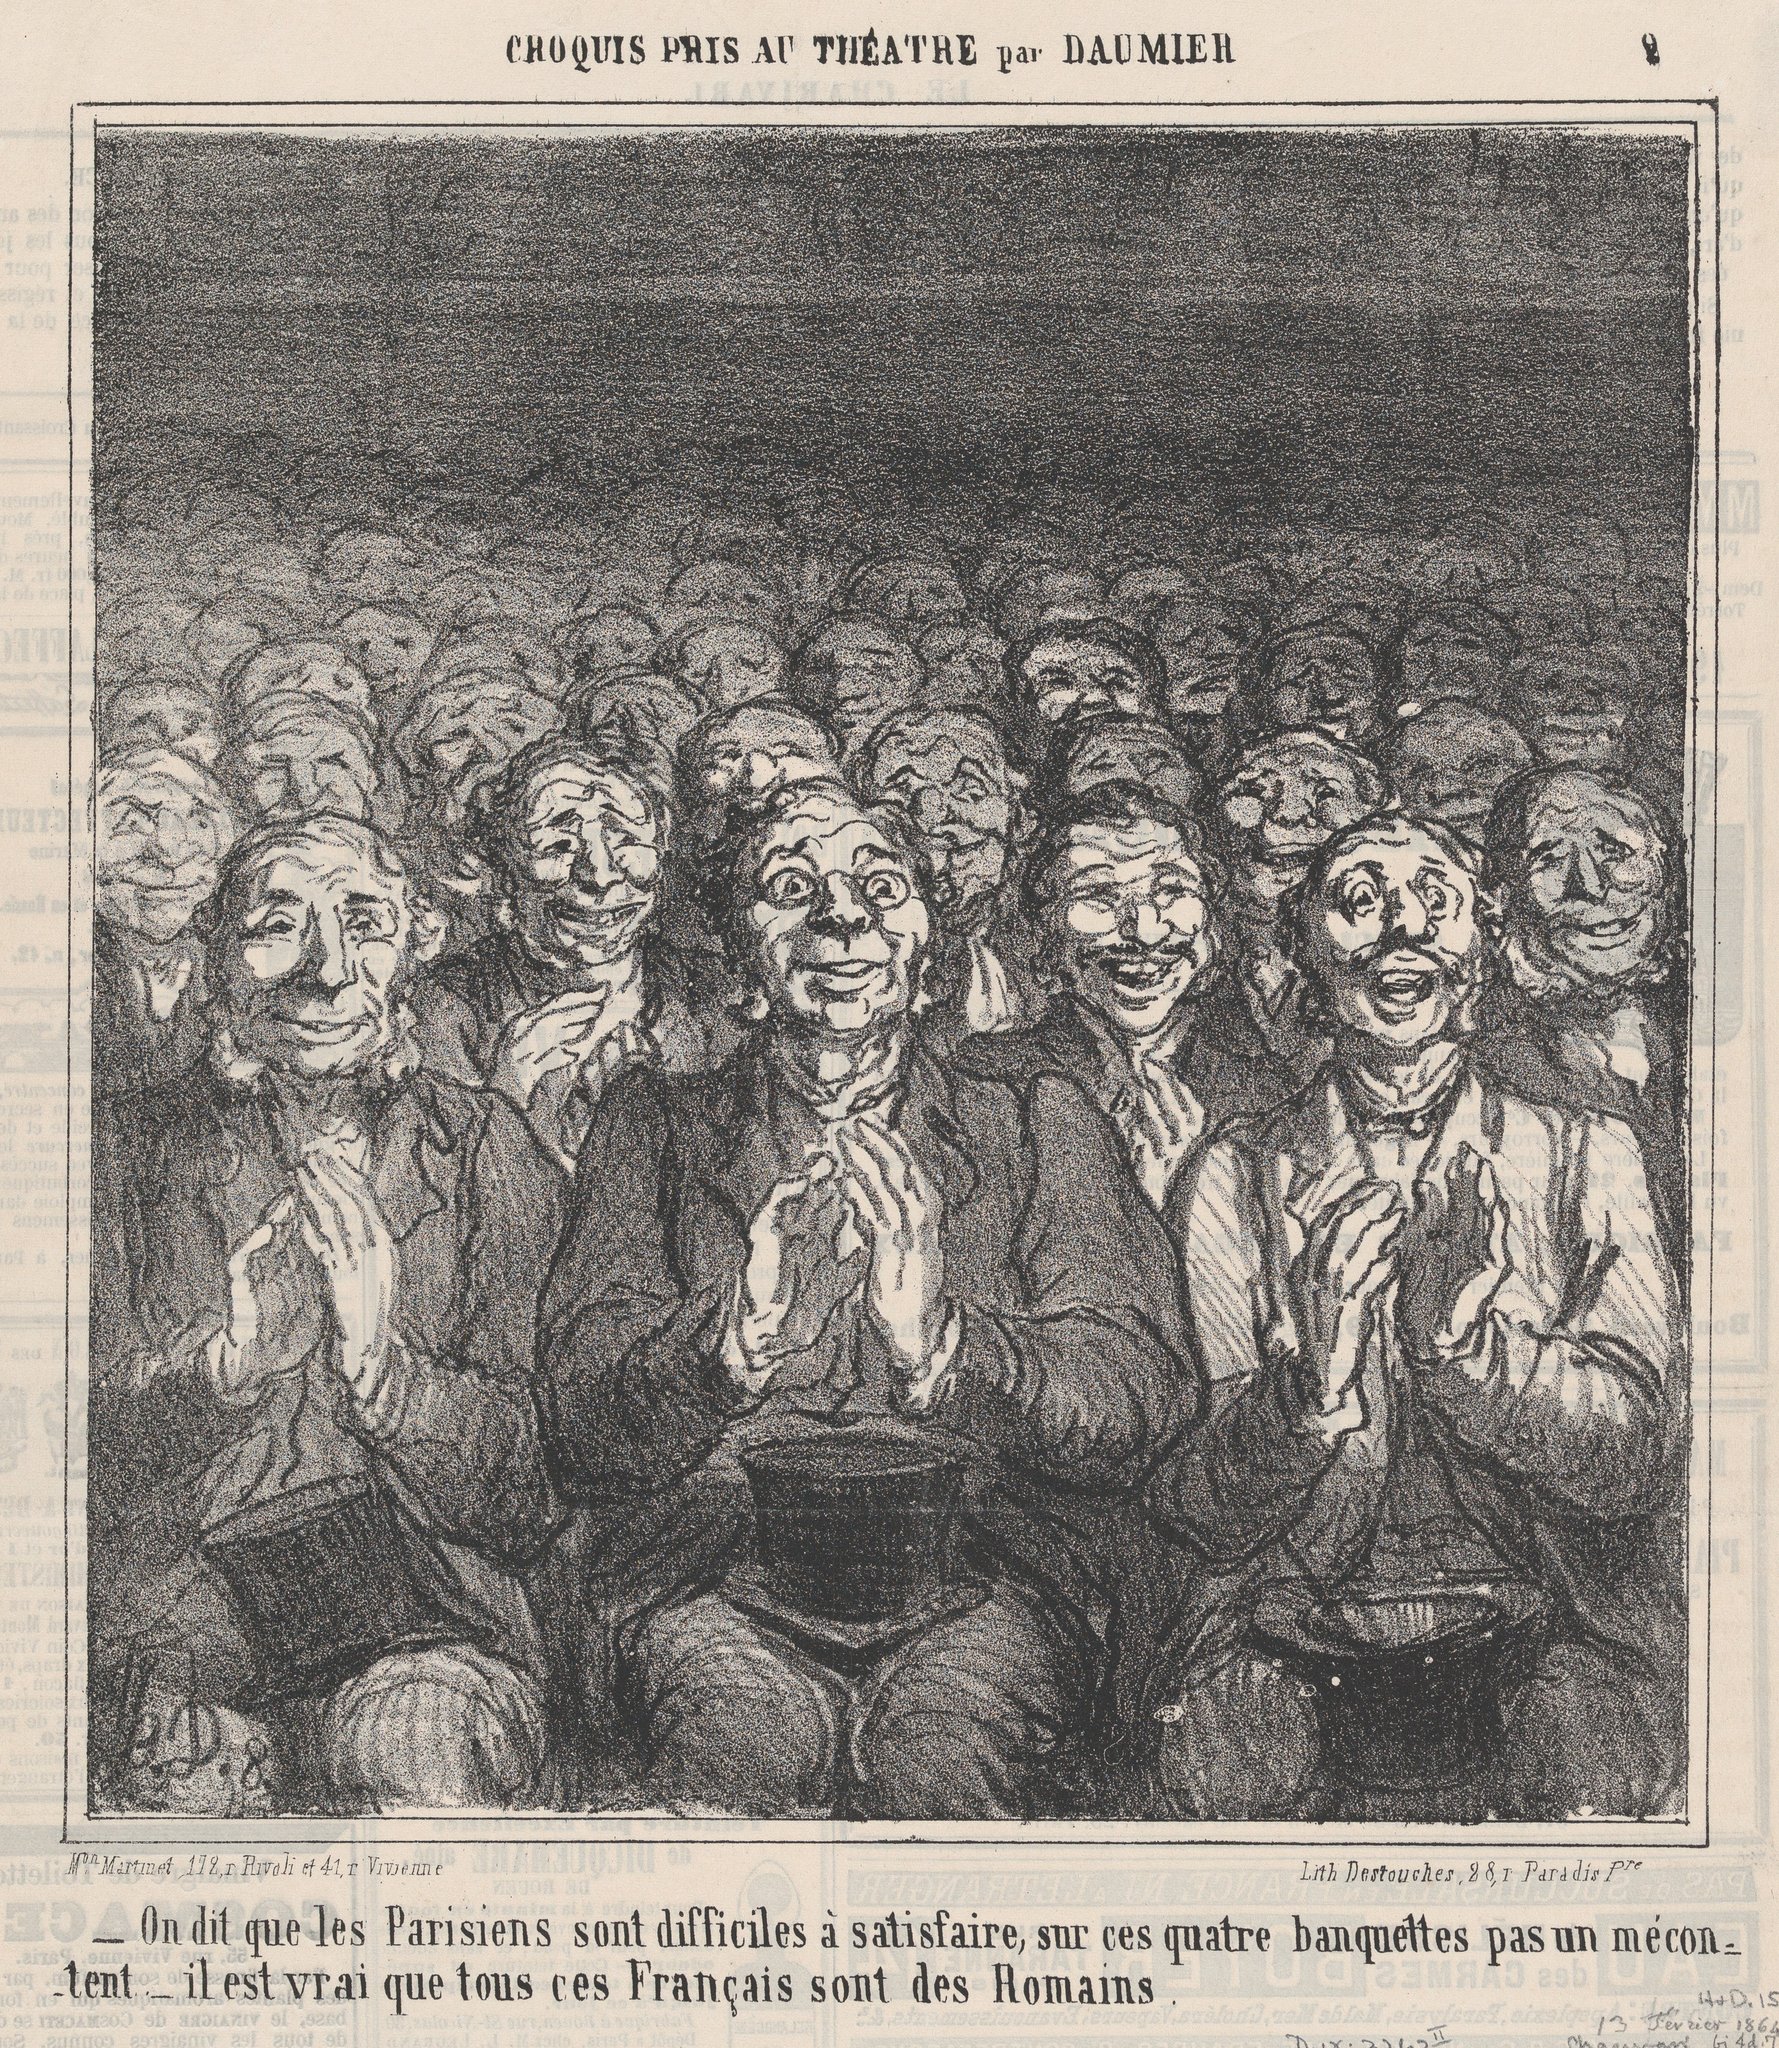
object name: print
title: Who says, Parisians are never satisfied!, from 'Theater sketches,' published in Le Charivari, February 13, 1864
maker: honoré daumier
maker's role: artist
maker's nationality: french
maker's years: 1808-1879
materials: paper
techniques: lithograph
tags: satire,men